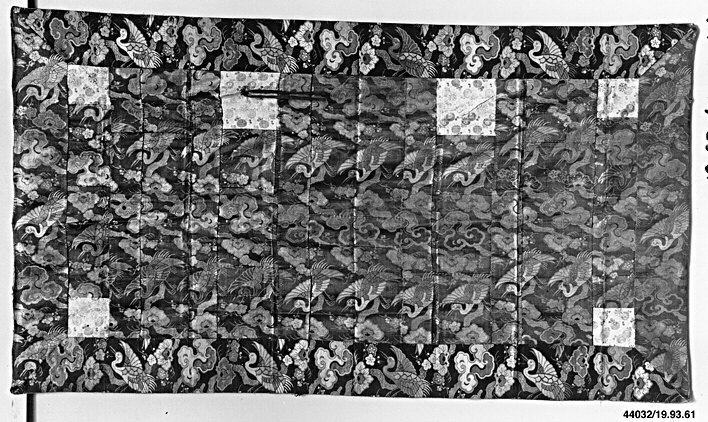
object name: robe, priest's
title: Priest's Robe (Shichijō)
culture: japanese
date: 1673-1681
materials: metal thread, silk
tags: birds